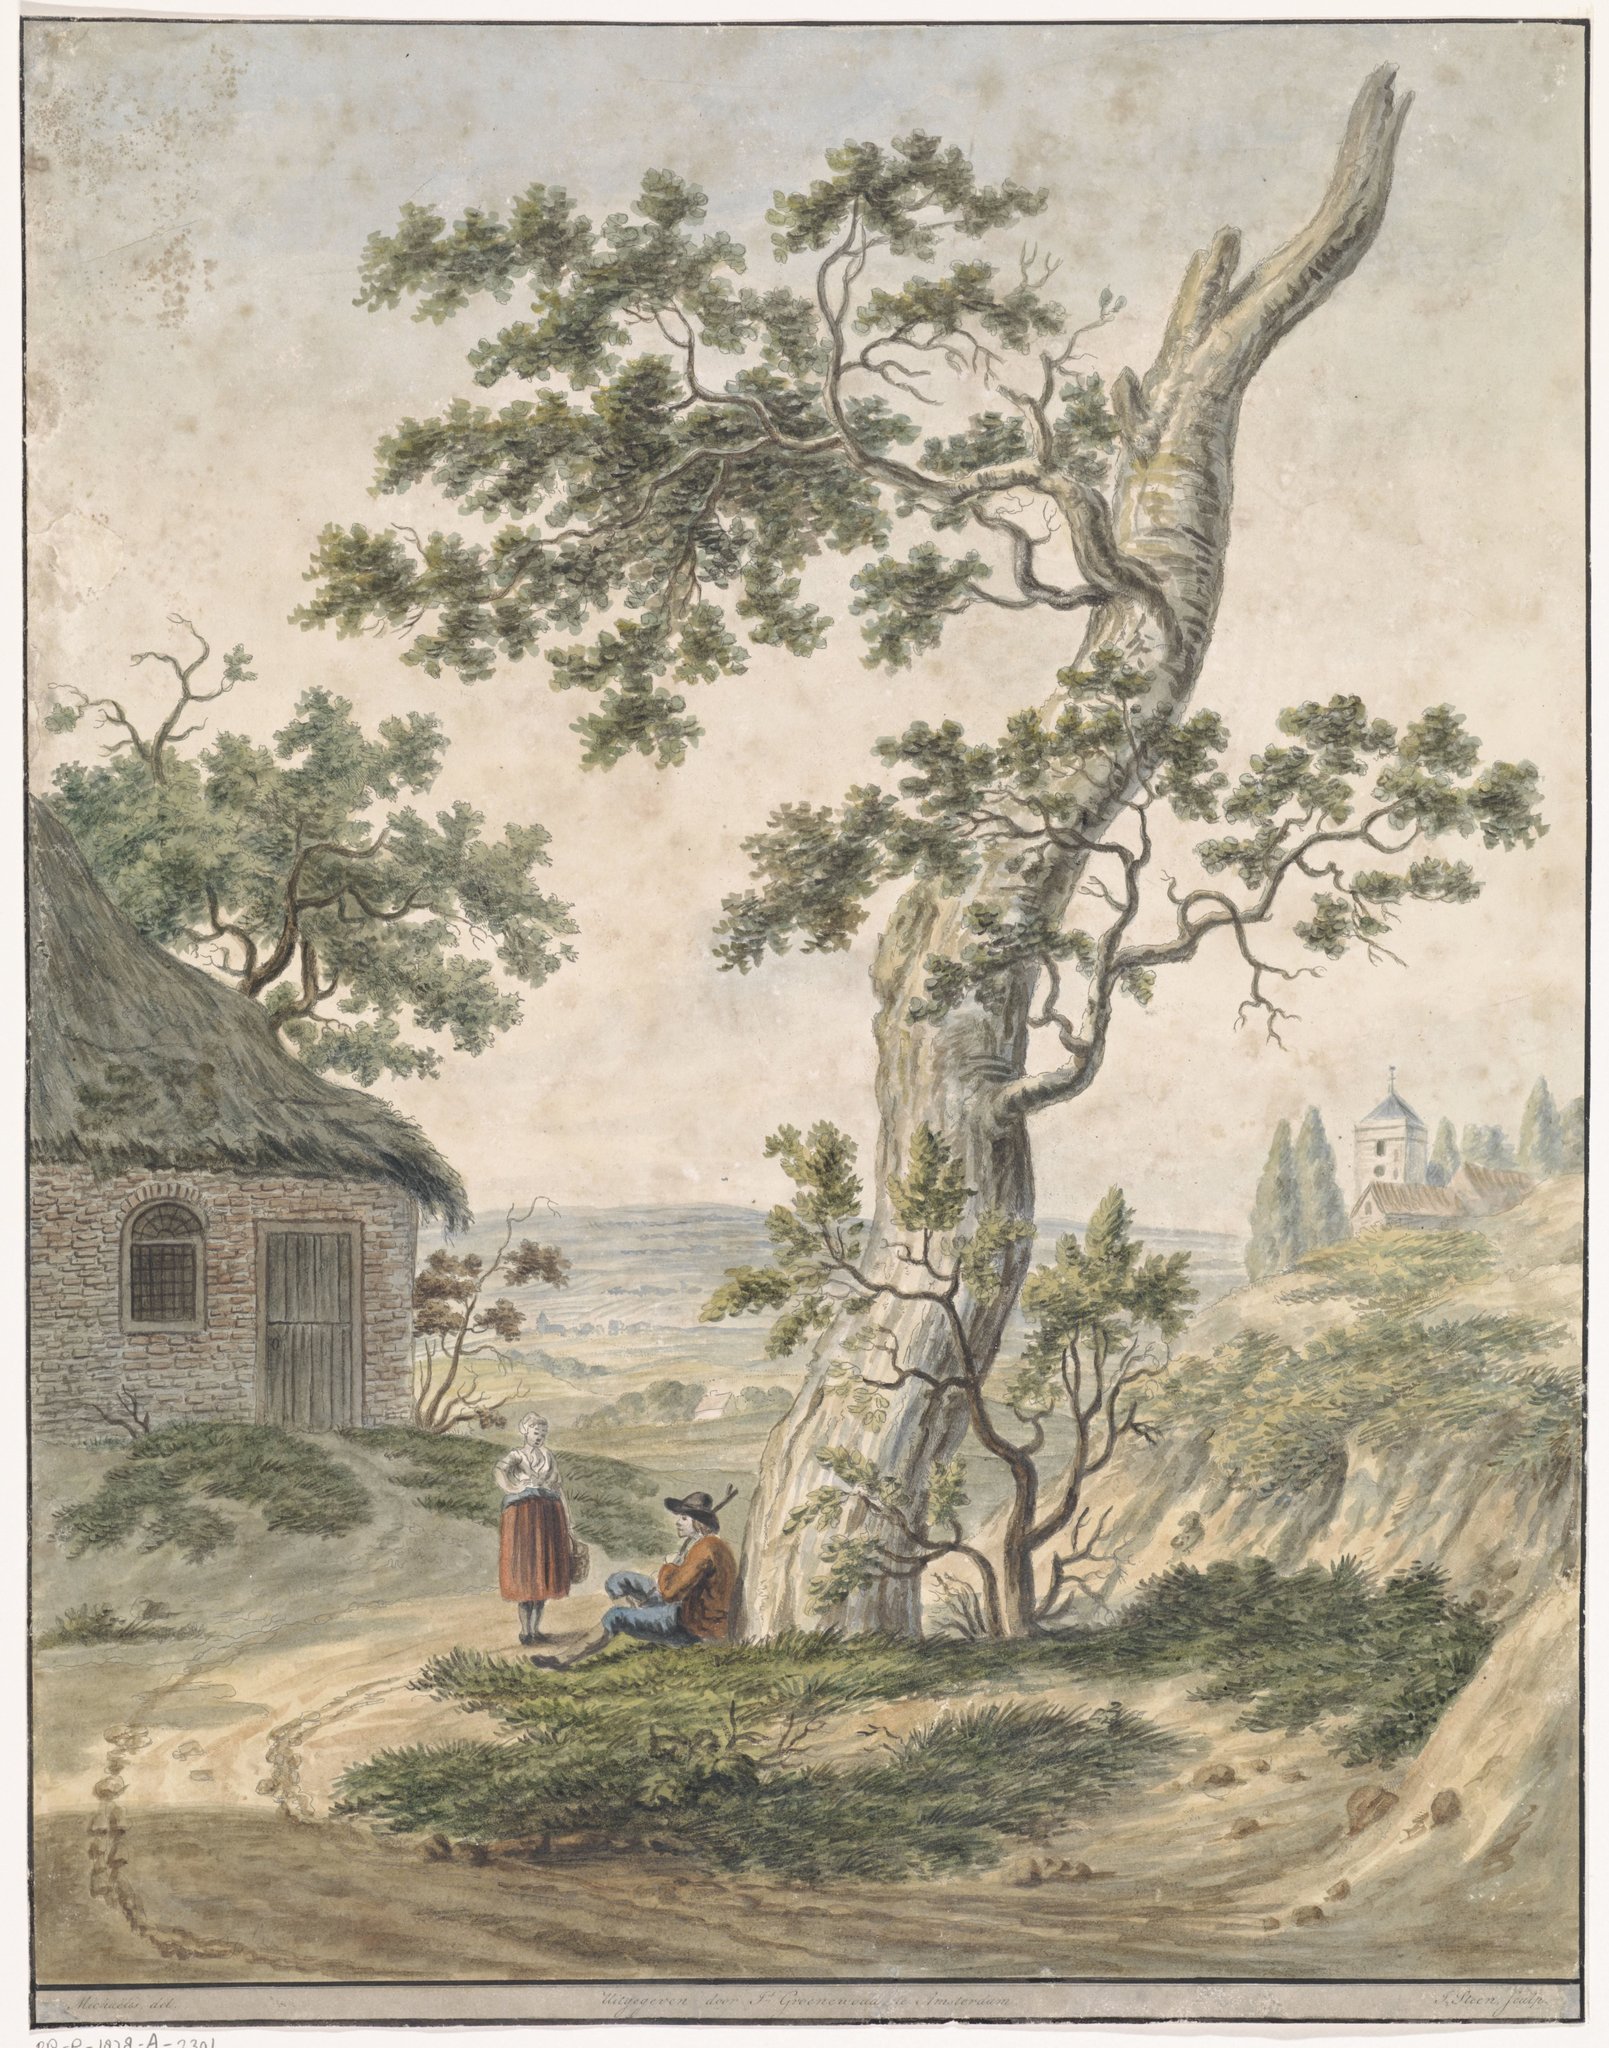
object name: print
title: Landschap met een man en vrouw bij een boom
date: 1773-1783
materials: paper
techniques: etching, hand coloring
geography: amsterdam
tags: trees, (high) hill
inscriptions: collector's mark: Lugt 2228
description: In een heuvelachtig landschap staat een boom. Onder de boom zit een man, die in gesprek is met een staande vrouw. Links een boerderij. Rechts daken van huizen en een kerktoren.